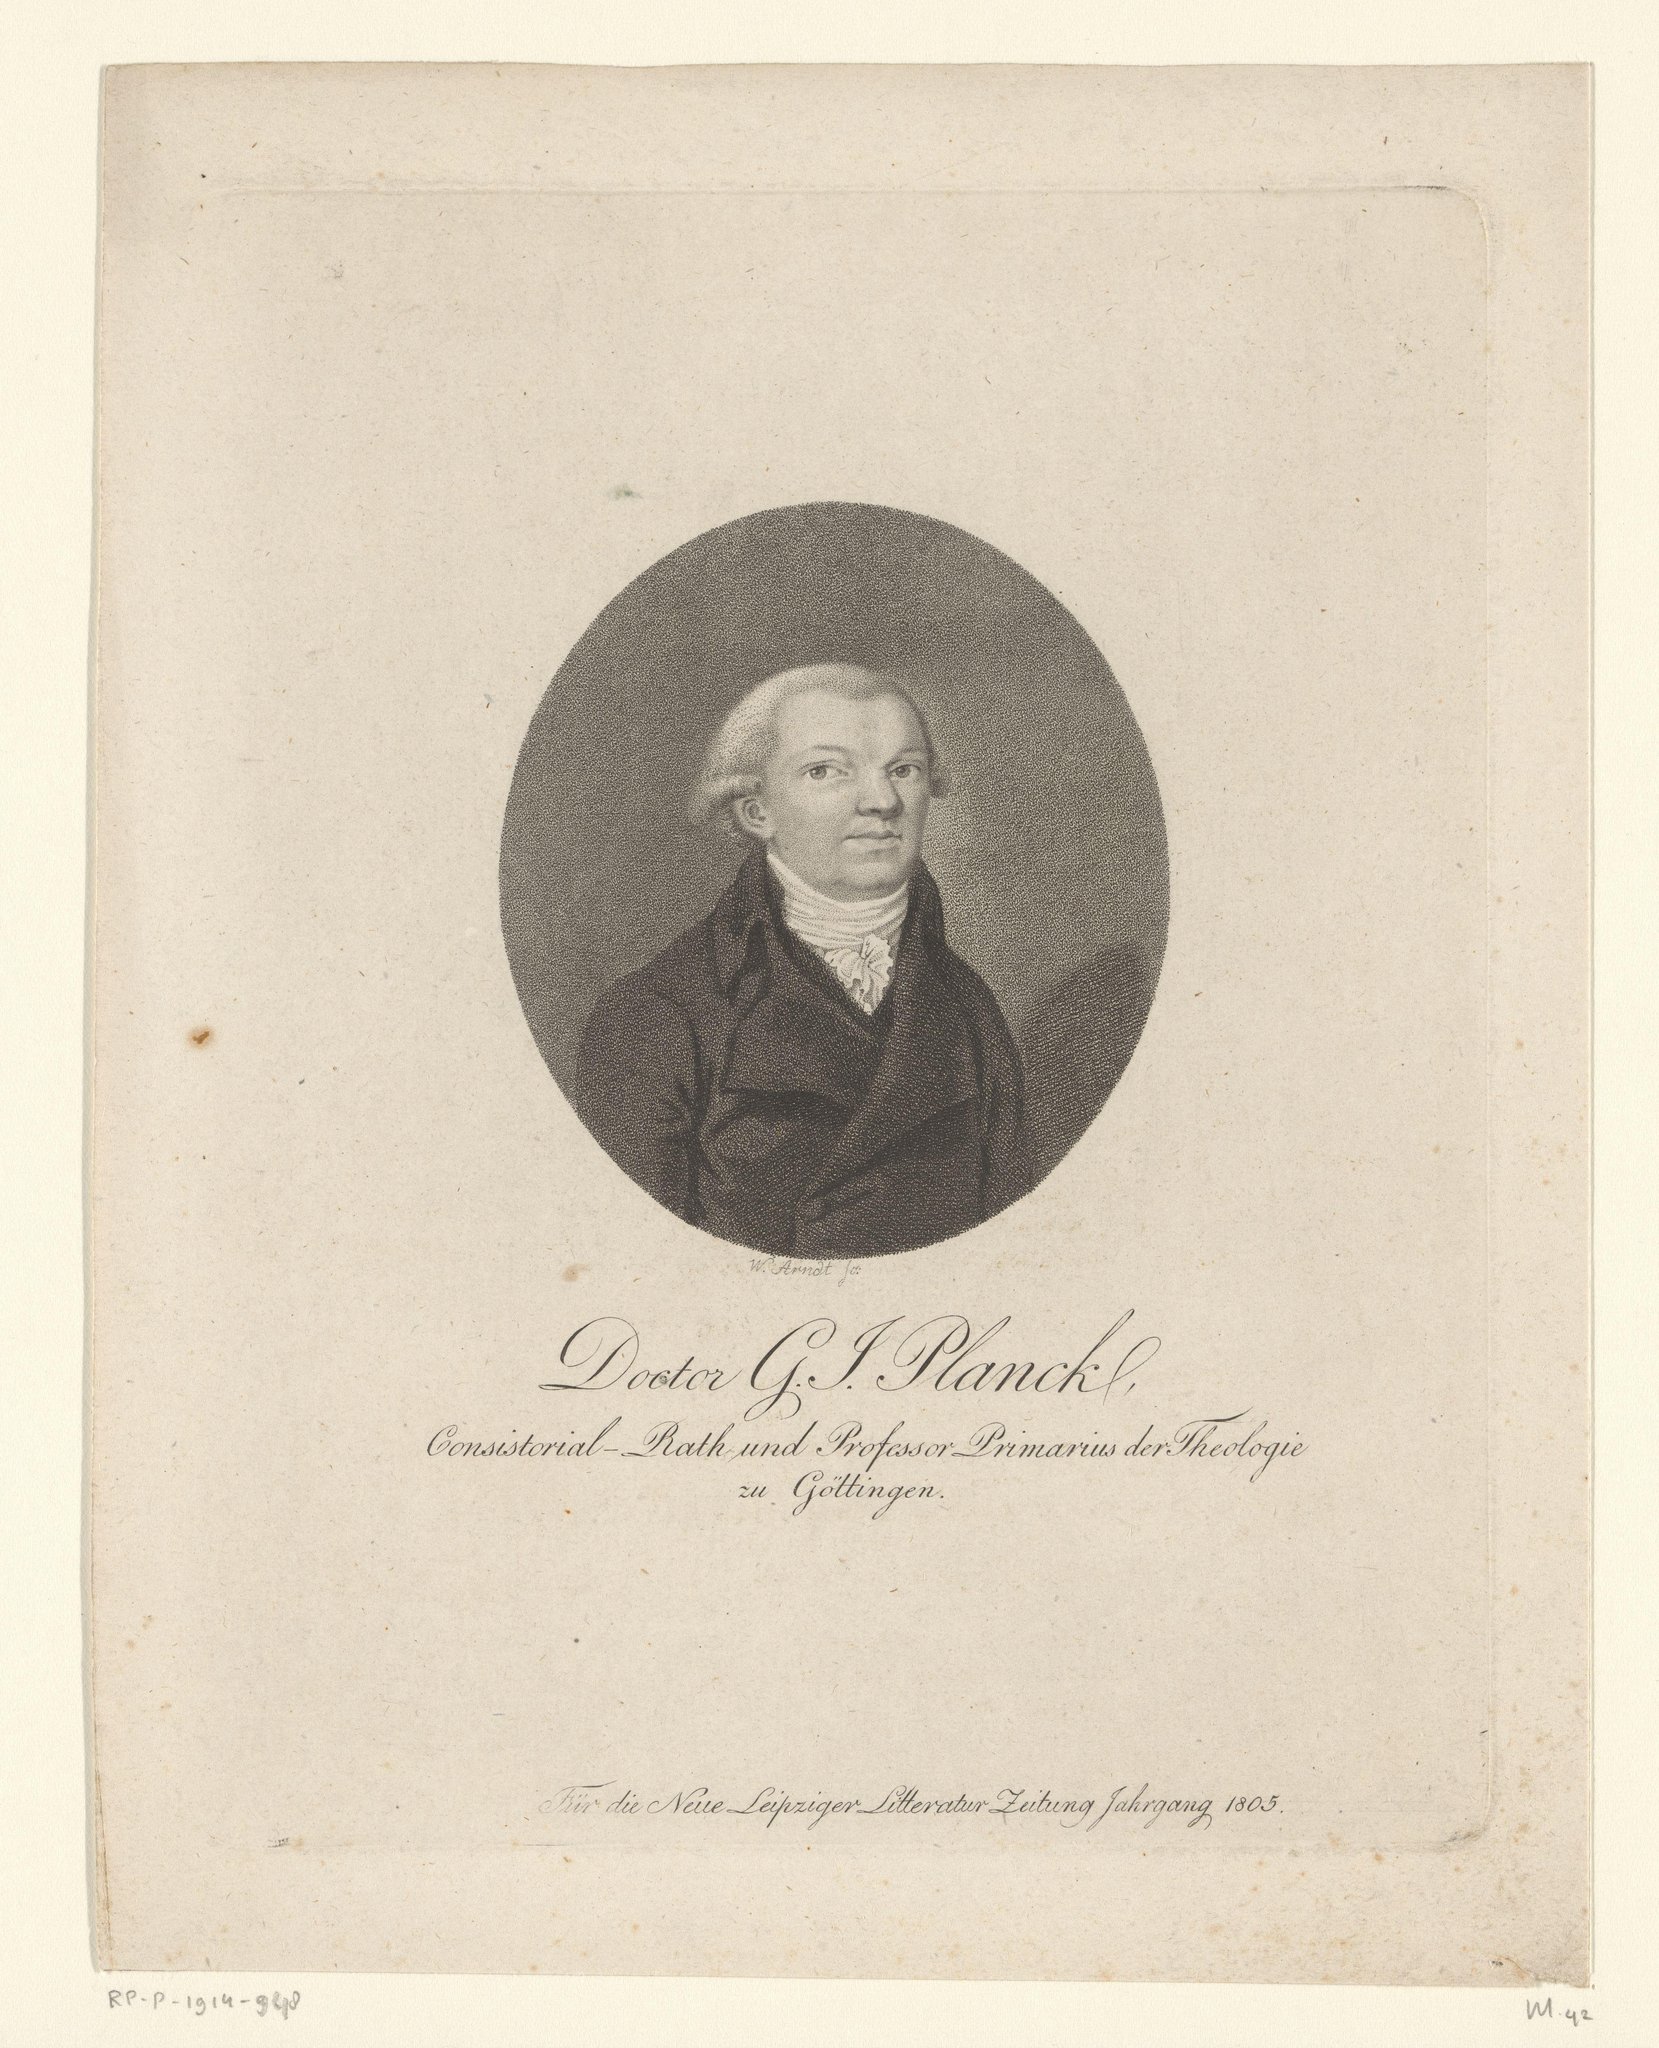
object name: print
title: Portret van Gottlieb Jakob Planck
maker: wilhelm arndt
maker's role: print maker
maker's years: 1750-1813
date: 1805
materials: paper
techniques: stippling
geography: leipzig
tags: historical persons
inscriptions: collector's mark: Lugt 2228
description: Uitgegeven in: Die Neue Leipziger Litteratur Zeitung, 1805.